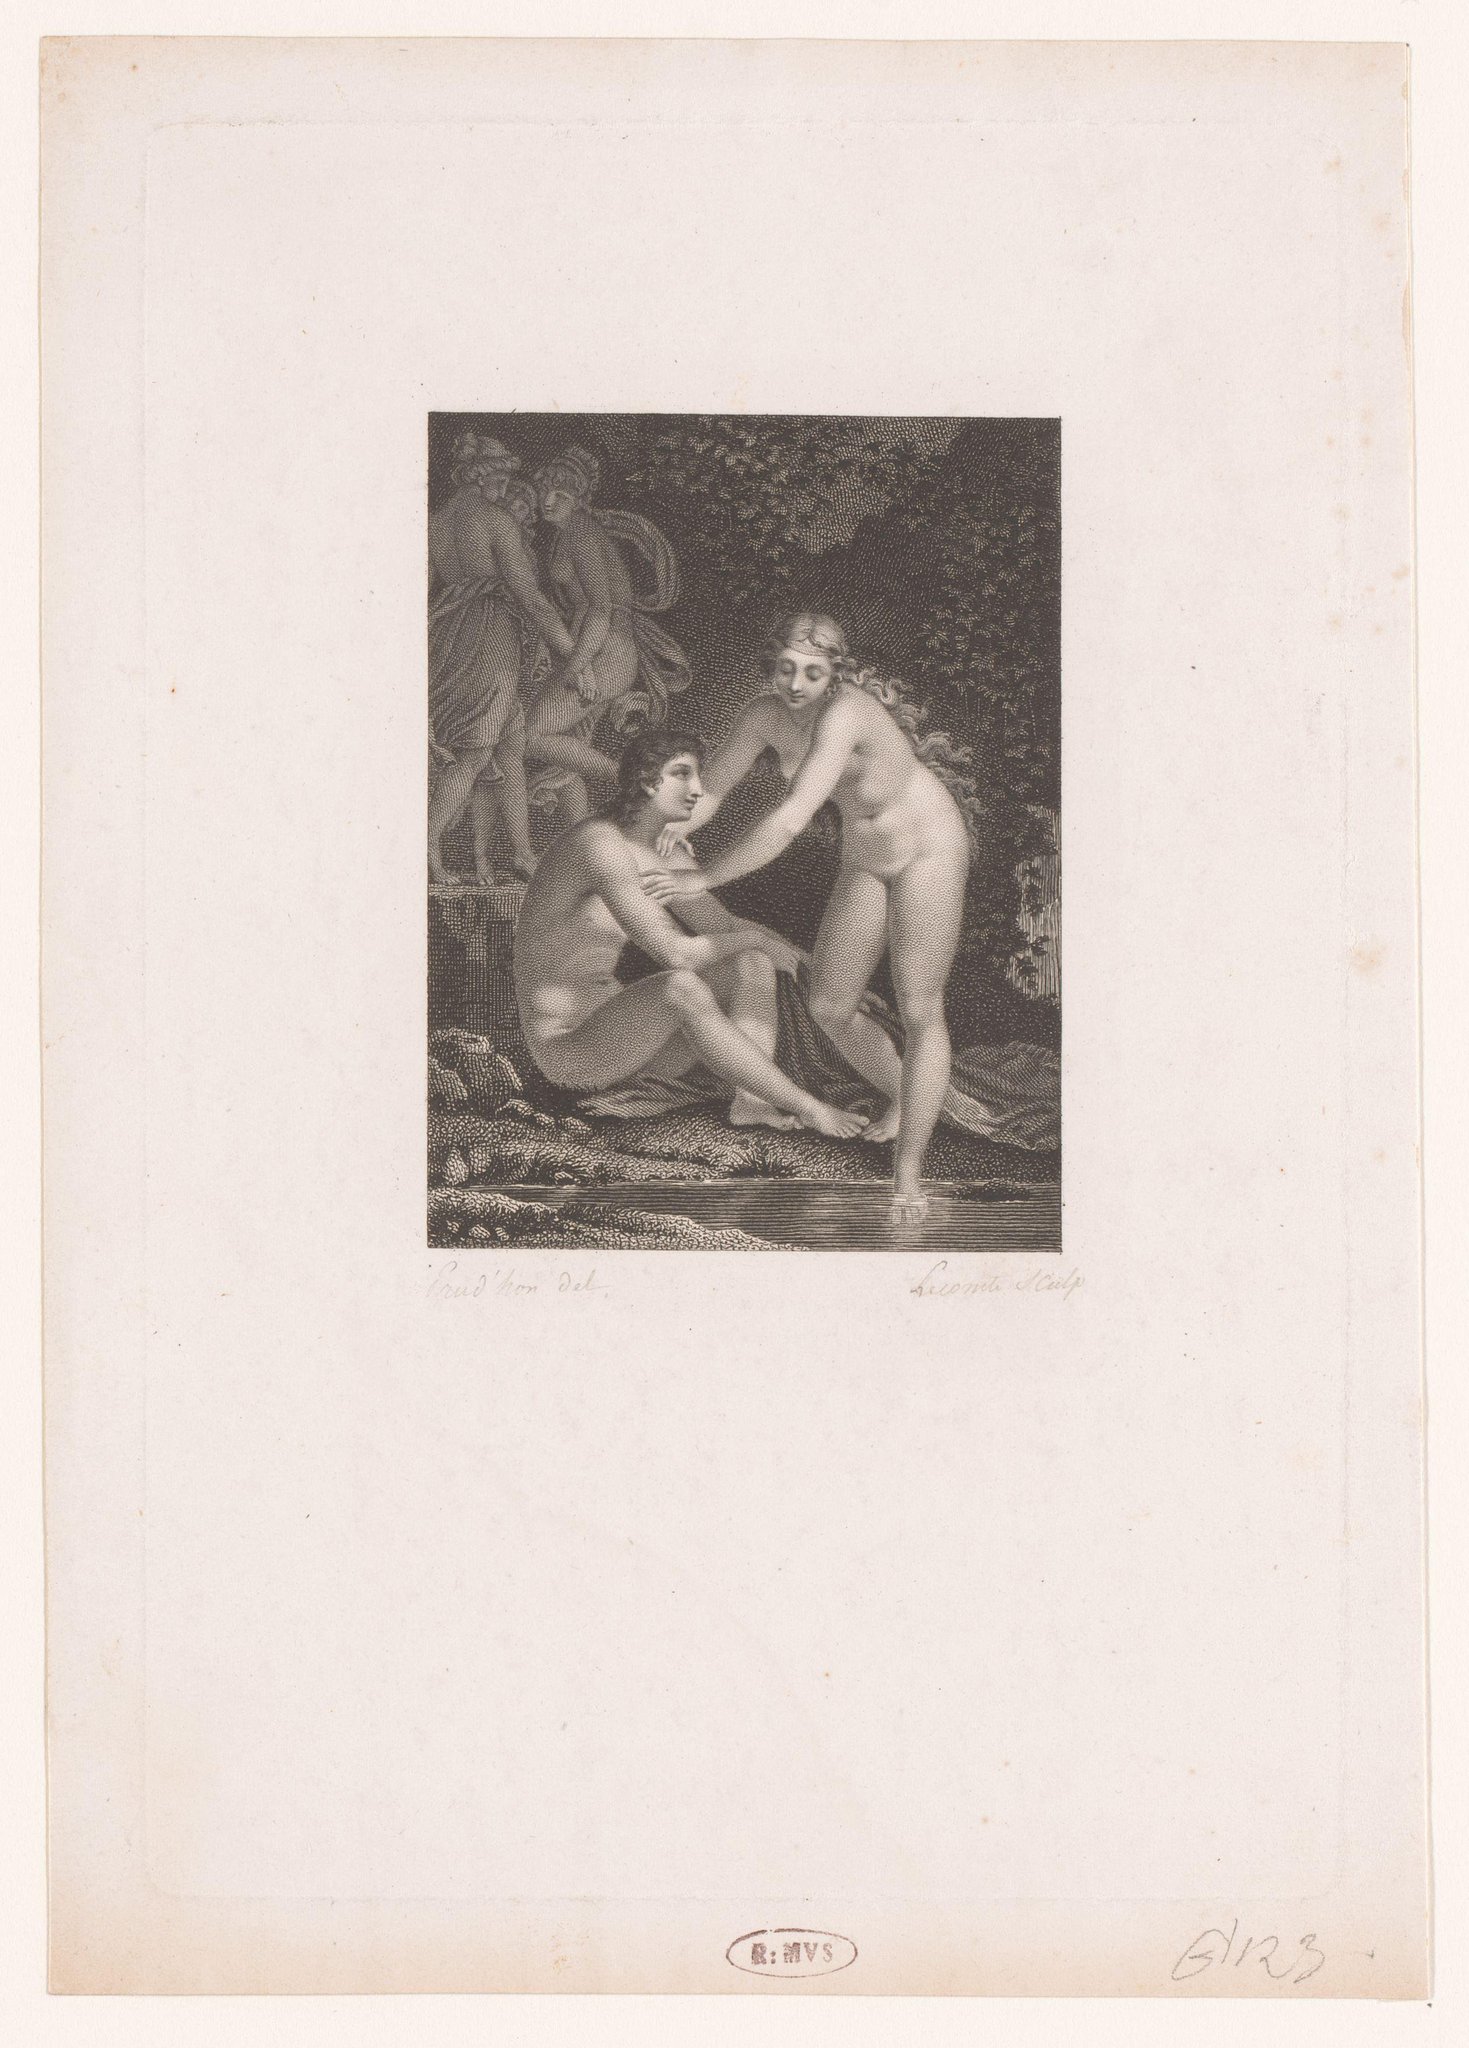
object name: print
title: Daphnis en Chloë badend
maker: hyacinthe louis victor jean baptiste aubry-lecomte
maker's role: print maker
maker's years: 1787-1858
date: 1807-1858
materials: paper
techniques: engraving, etching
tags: daphnis (in greek mythology a shepherd who invented pastoral poetry, chloe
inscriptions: collector's mark: Lugt 2228